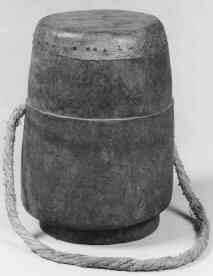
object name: drum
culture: kenyan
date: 1801-1900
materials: fiber, skin, wood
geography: kenya